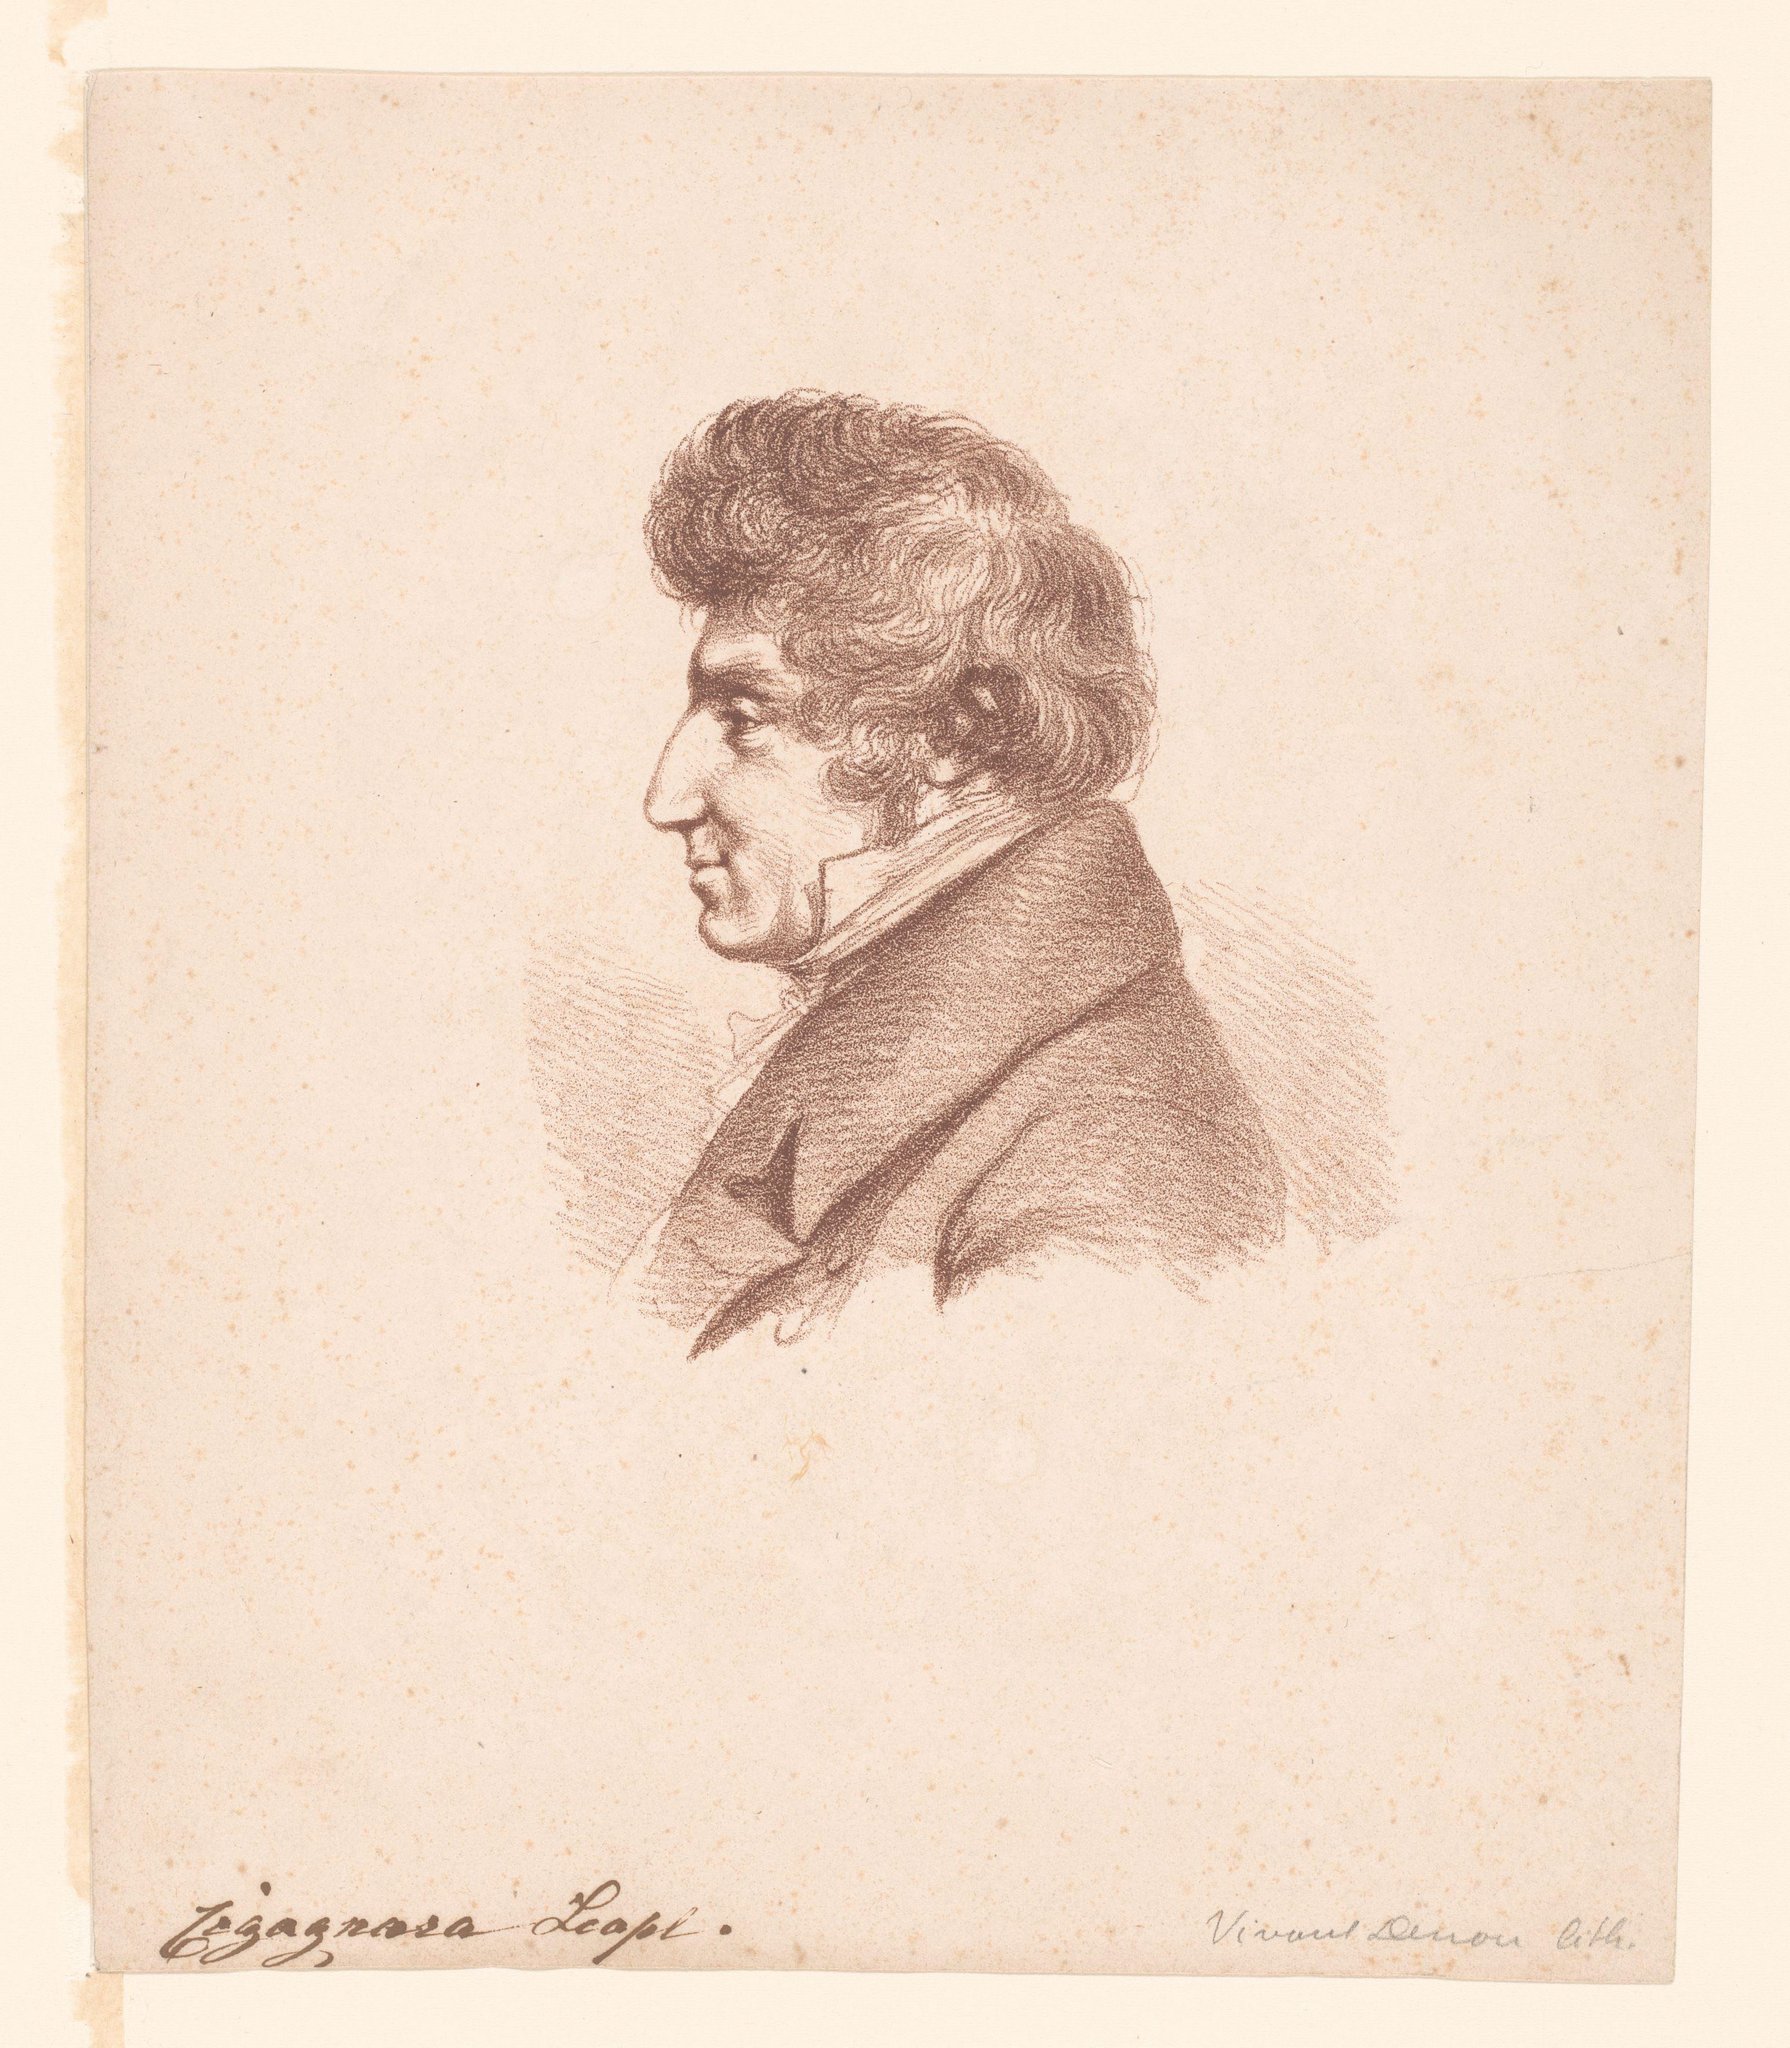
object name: print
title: Portret van graaf Leopoldo Cicognara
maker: dominique vivant denon (baron)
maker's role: draughtsman, print maker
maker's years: 1747-1825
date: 1825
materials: paper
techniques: lithography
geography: paris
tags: venice, leopoldo cicognara, historical persons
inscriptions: collector's mark: Lugt 2228a